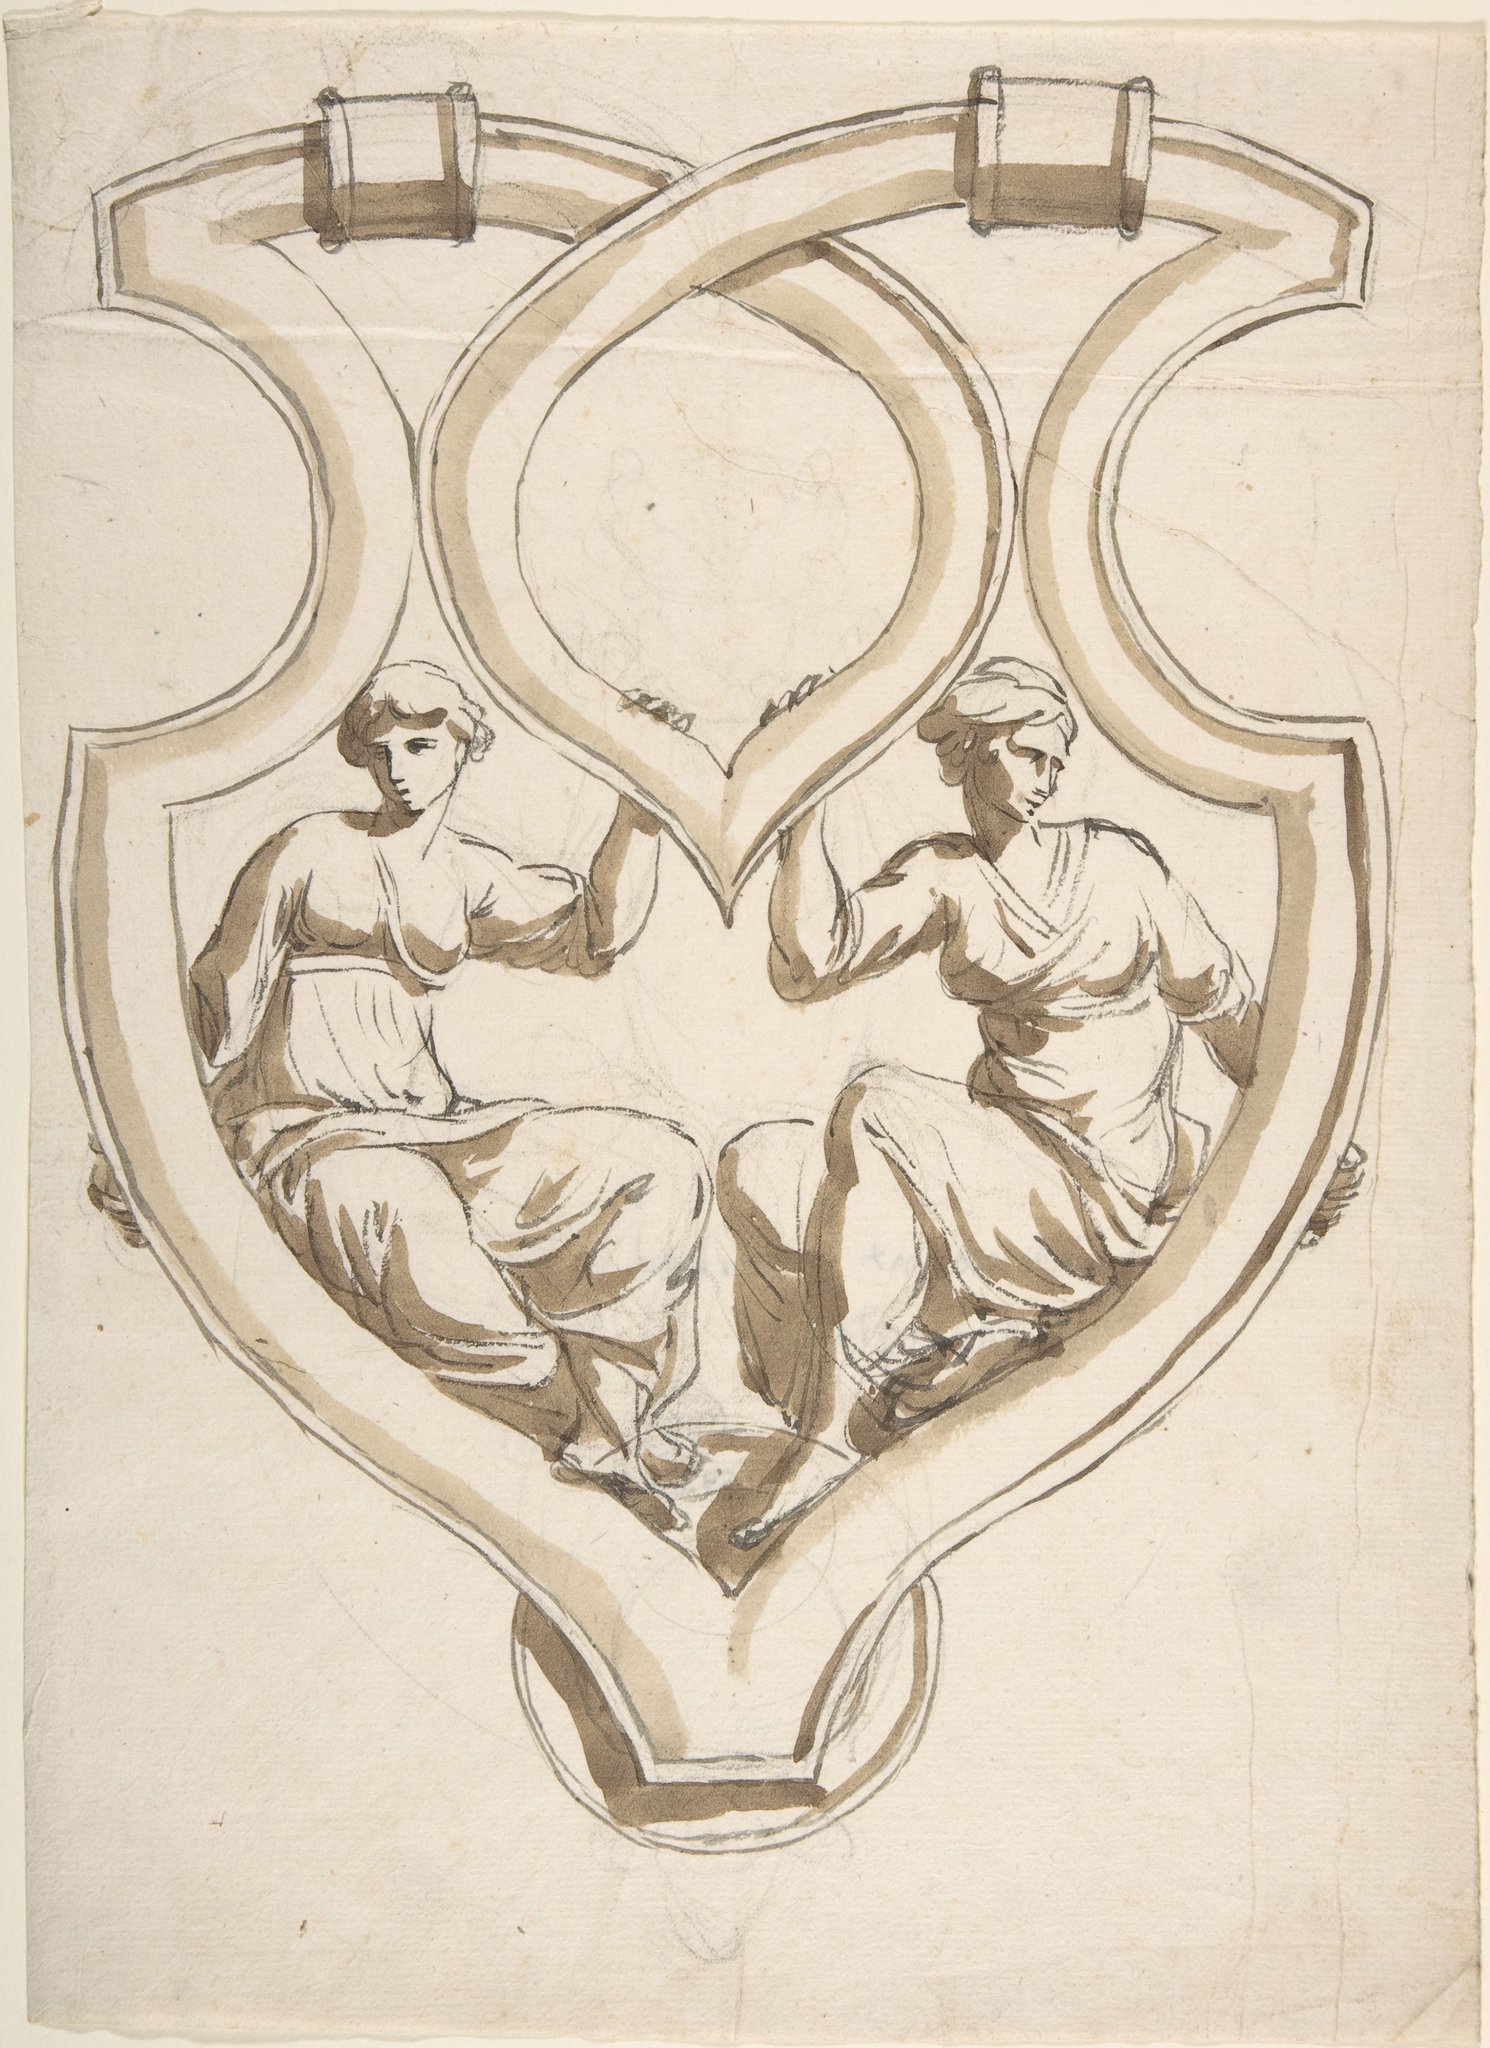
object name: drawing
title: Two Female Figures in Interlaced Cartouche Design for Door Knocker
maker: anonymous, french, 19th century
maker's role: artist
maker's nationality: french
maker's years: 1800-1900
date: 1801-1900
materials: graphite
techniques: brush, wash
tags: cartouches,women